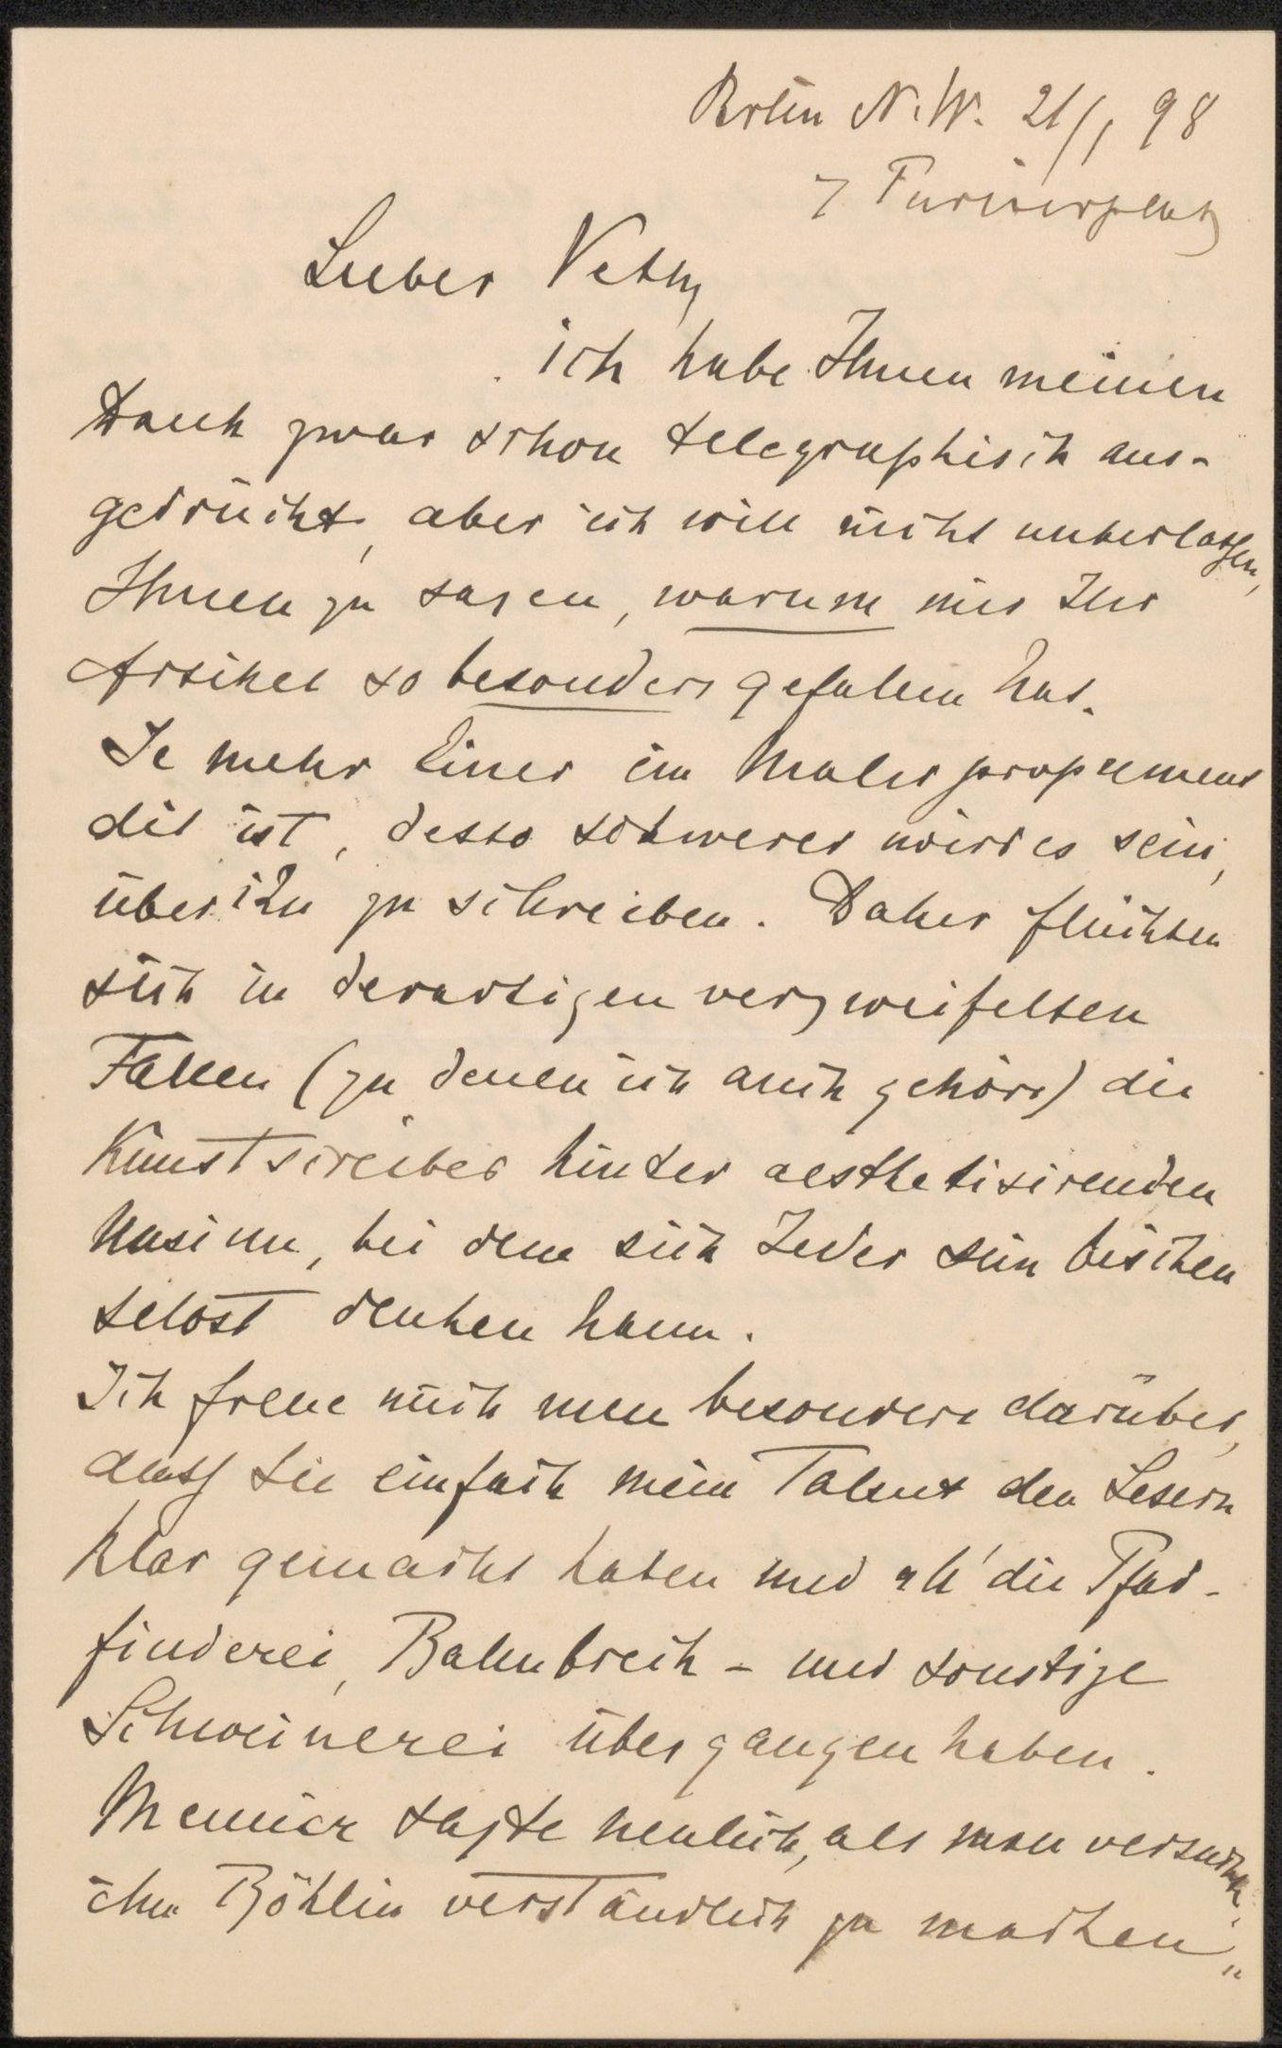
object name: letter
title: Brief aan Jan Veth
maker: max liebermann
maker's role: draughtsman, print maker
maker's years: 1847-1935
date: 1898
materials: ink, paper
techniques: pen, writing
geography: berlin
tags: dordrecht, amsterdam, painter, designer, jan veth, print maker, constantin emile meunier, johan barthold jongkind, berlin, wilhelm von bode, the graphic arts, money, printed matter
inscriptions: collector's mark: ‘RPK’, watermark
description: Opgenomen in: Ernst Braun, Max Liebermann: Briefe 1896-1901, Baden-Baden: Deutscher Wissenschafts-Verlag, 2012, Band 2, p. 192-194.